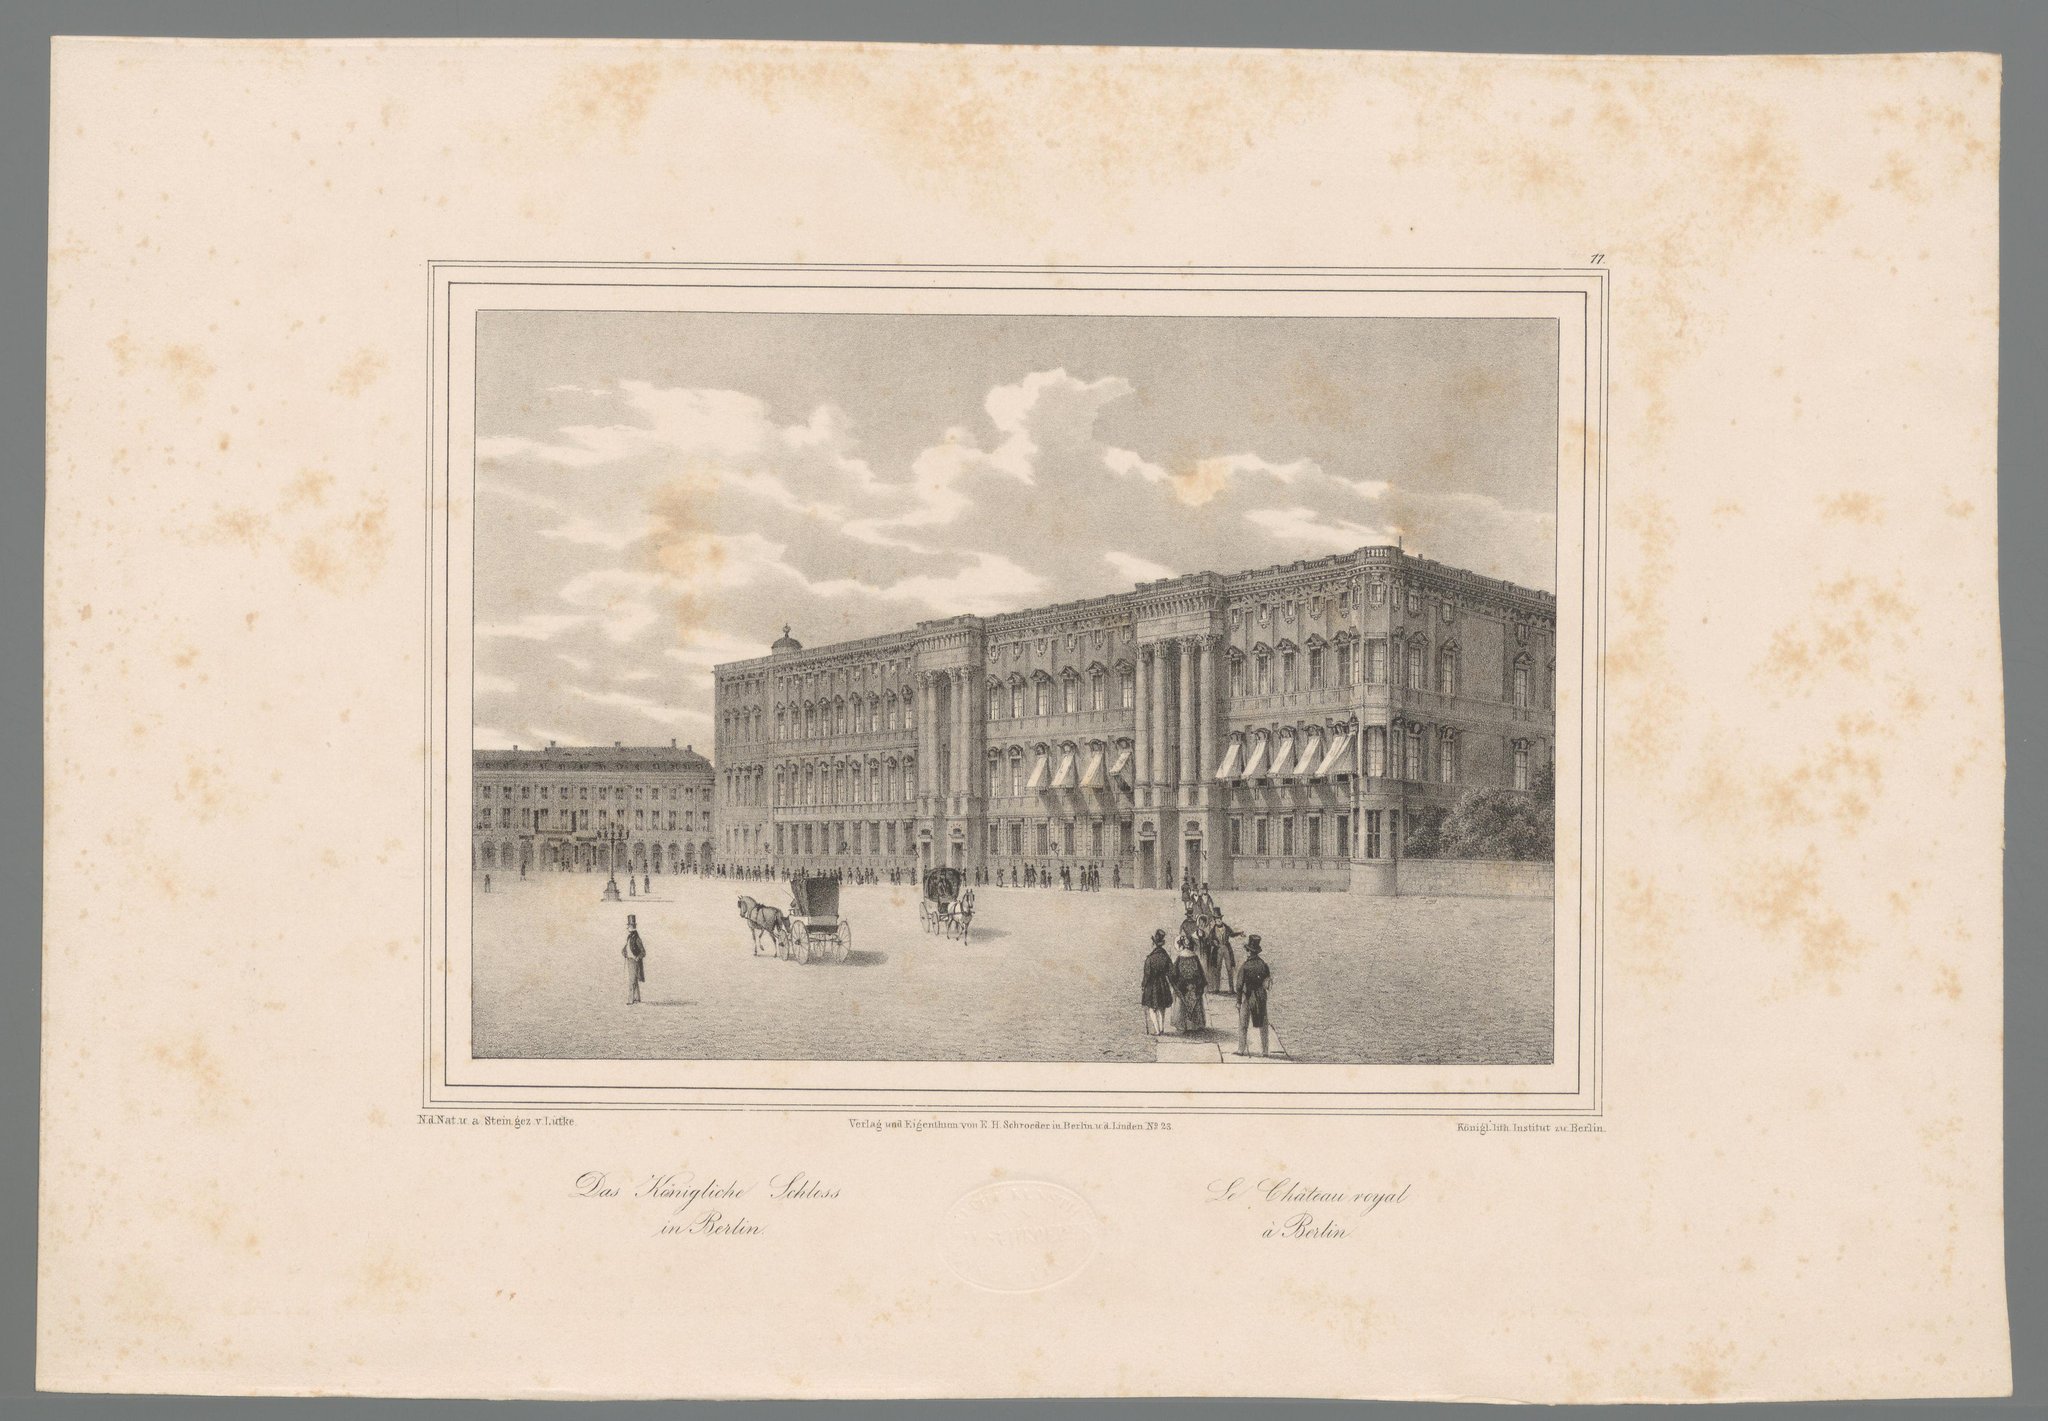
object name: print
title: Das Königliche Schloss in Berlin / Le Château royal à Berlin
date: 1840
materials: paper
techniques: lithograph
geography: berlin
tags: city-view in general; 'veduta', hôtel, i.e. small palace in city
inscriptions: check stamp: ‘Buch u. Kunsth. von E.H. Schroeder in Berlin’, collector's mark: Lugt 2228